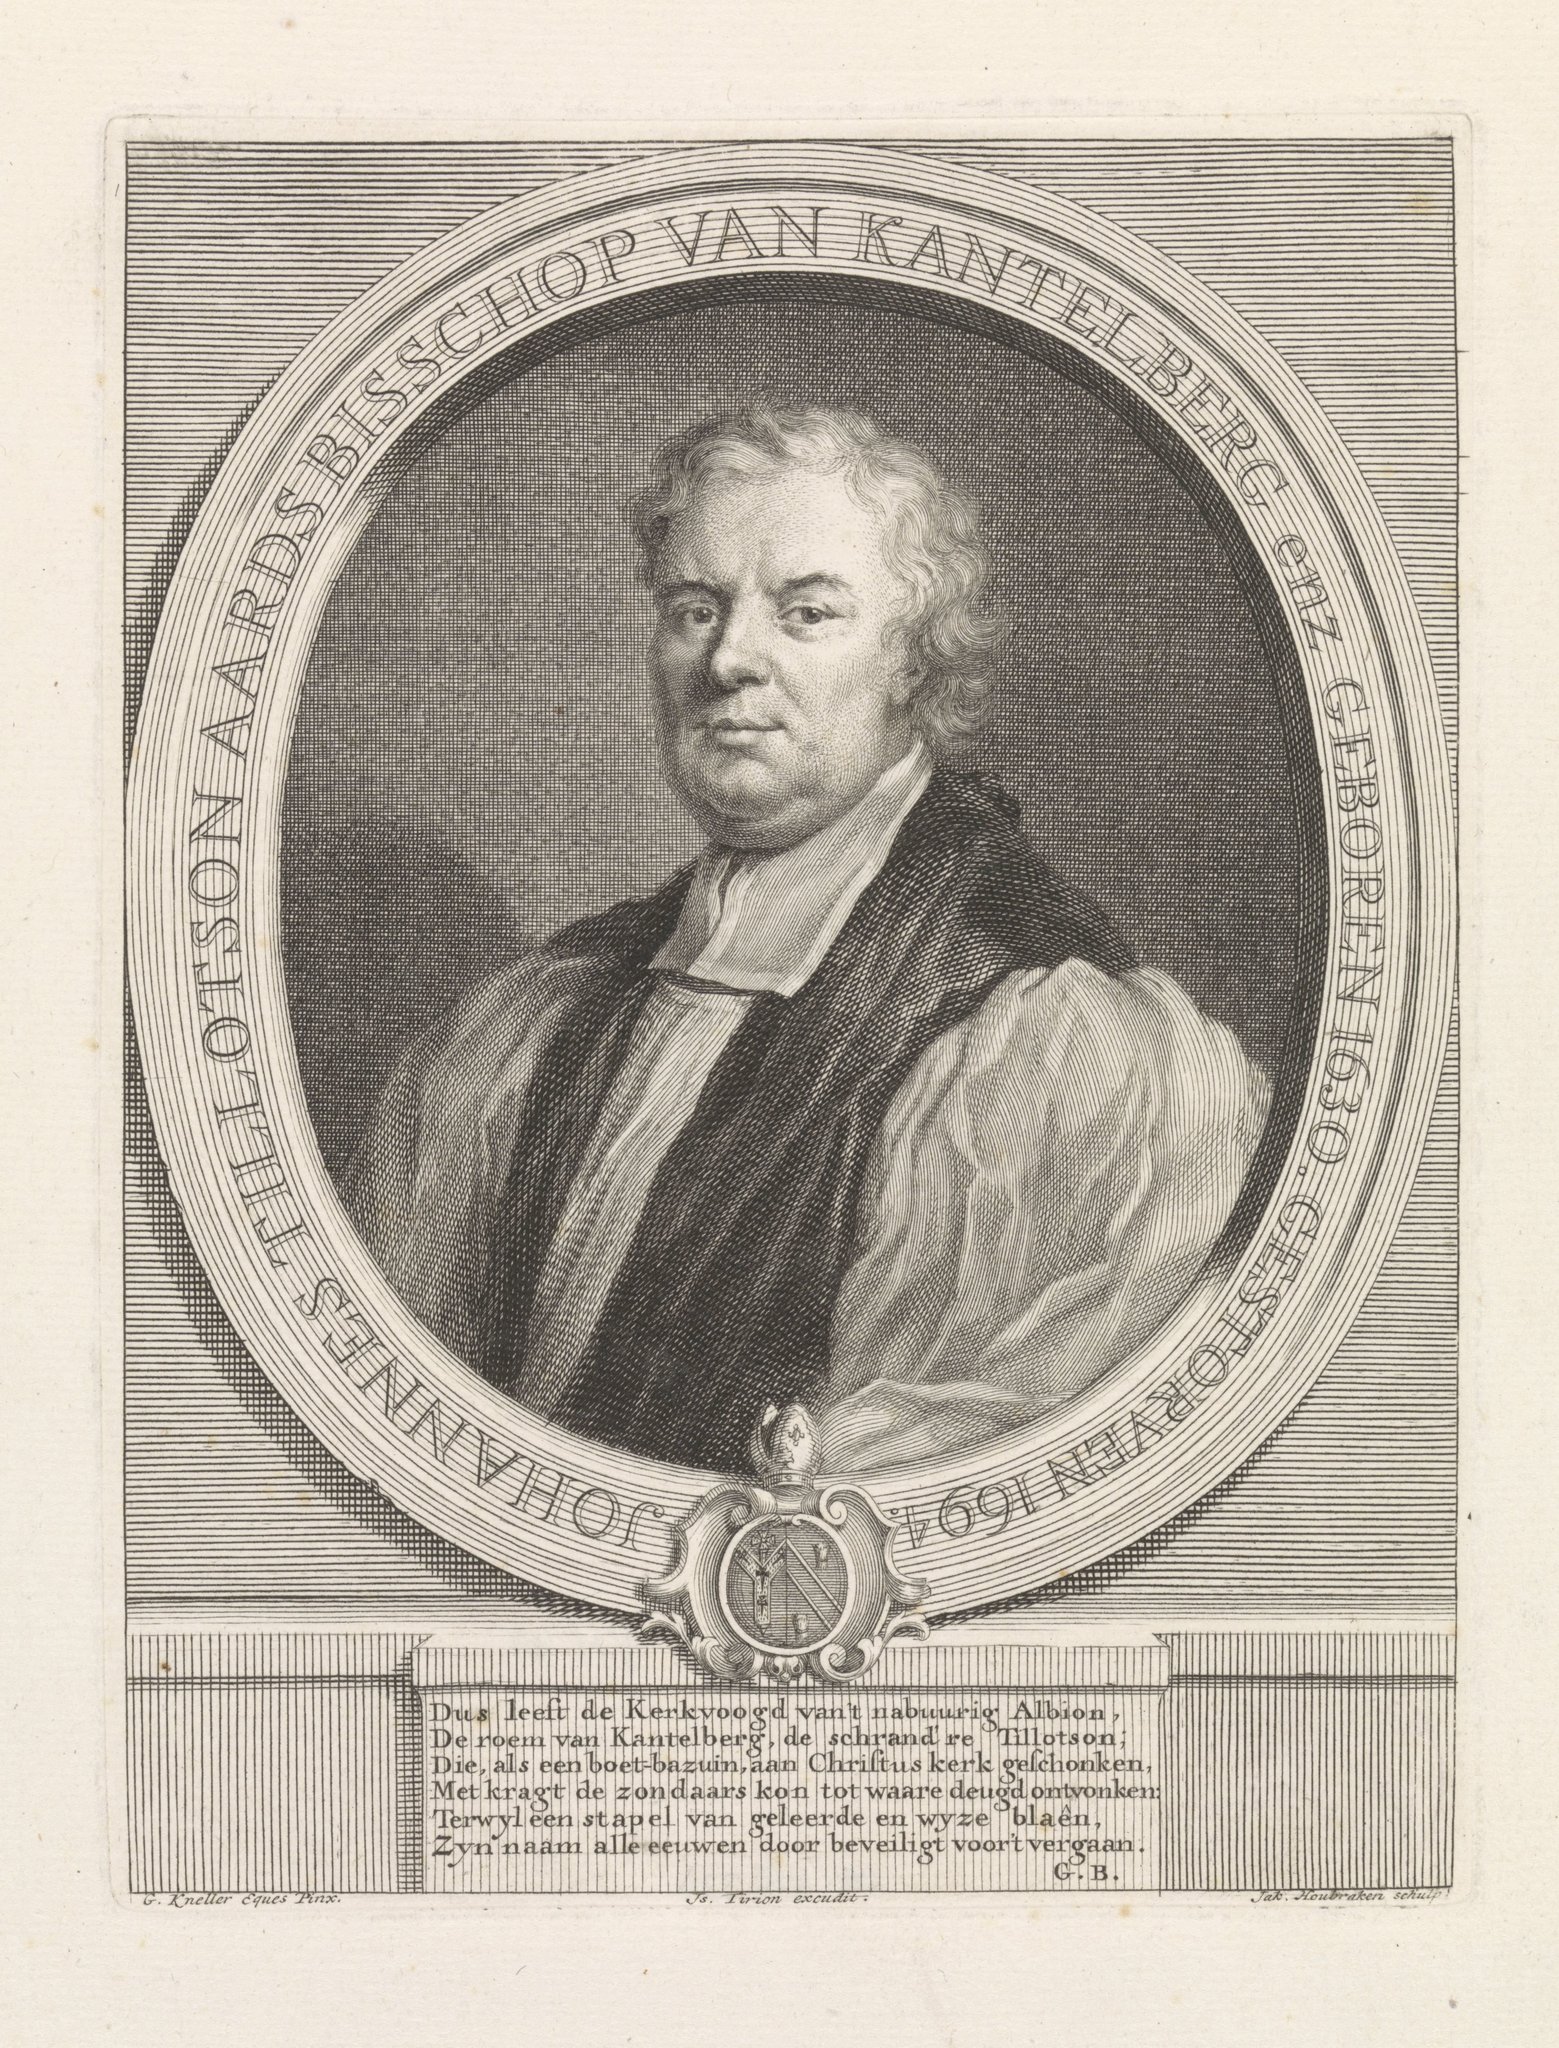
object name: print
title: Portret van John Tillotson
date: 1729-1766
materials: paper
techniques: engraving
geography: amsterdam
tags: clergyman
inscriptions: collector's mark: Lugt 240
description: Buste naar links van John Tillotson, aartsbisschop van Canterbury, in een ovaal met randschrift in het Nederlands en met onderaan zijn wapen. Het portret rust op een richel waarop een zesregelig vers in het Nederlands.